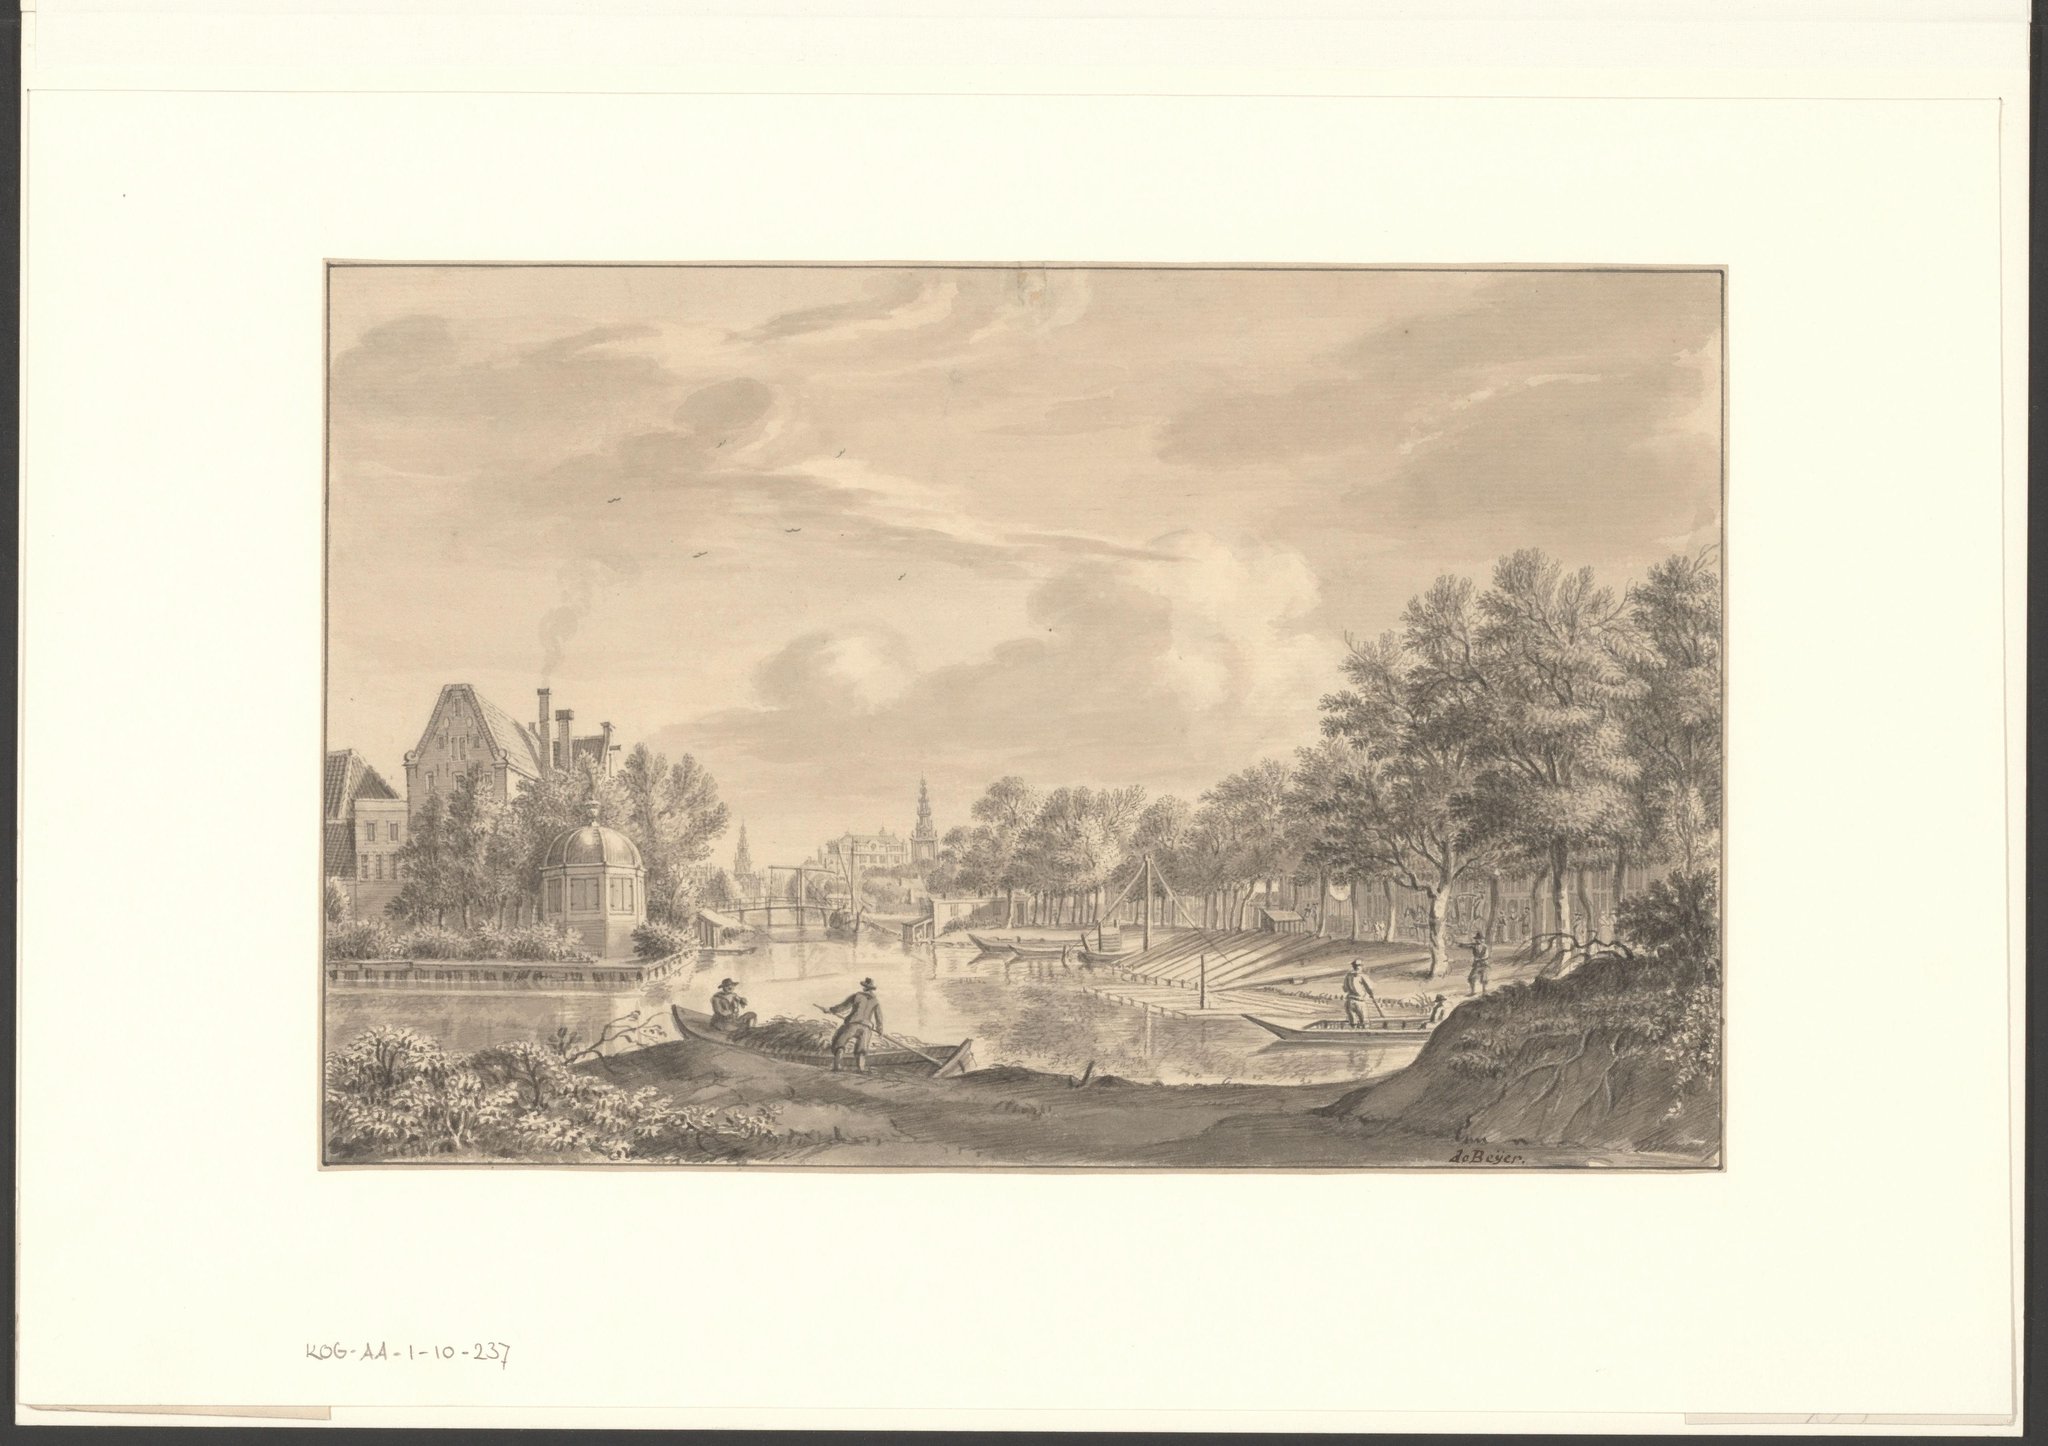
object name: drawing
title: Gezicht op de Plantage Muidergracht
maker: jan de beijer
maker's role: draughtsman, print maker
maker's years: 1703-1780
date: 1713-1780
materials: ink, paper, pencil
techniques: brush, pen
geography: amsterdam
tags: city-view in general; 'veduta', canal, boat propelled by man or animal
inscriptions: inscription: ‘op keerweer in de plantage / Muidergracht’, collector's mark: ‘10’ Lugt 1641b, inscription: ‘op Keermeer in de Plantage’, inscription: ‘Port. 10-237’, signature: ‘de Beijer.’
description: Onderwerpsrubriek binnen de Atlas Amsterdam: Maagdelievenstraat, Markenplein, Marnixstraat, Martelaarsgracht, Meeuwenlaan, Mennonietenpad, Meijerplein (Jonas Daniël), Mozes en Aäronstraat, Muidergracht, Muntplein.